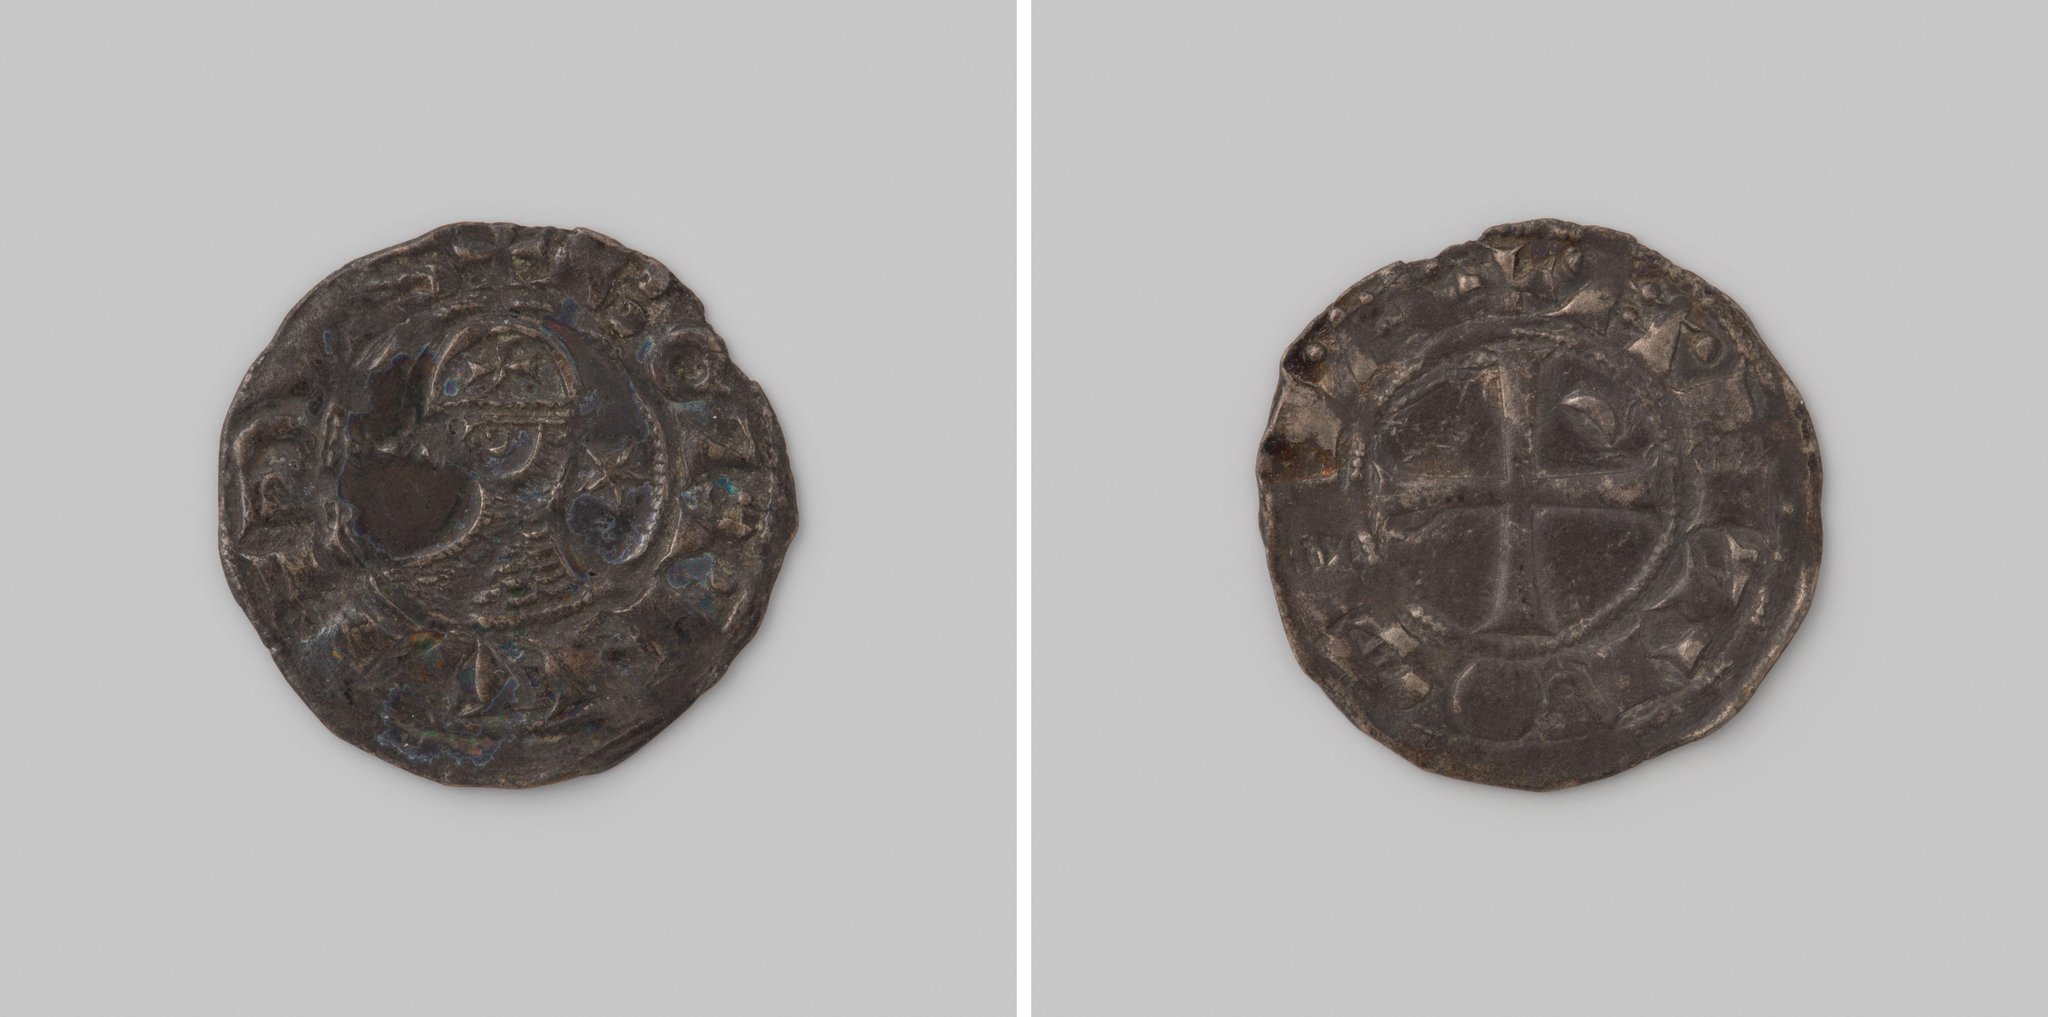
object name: coin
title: Vorstendom Antiochië, Bohemomd II,1201-1232, penning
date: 1201-1232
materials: silver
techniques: striking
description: Zilveren munt. Voorzijde: borstbeeld van de vorst met op zijn hoofd helm, waarop kruis. Rechts van hem ster. Keerzijde: kort gevoet kruis met in de eerste hoek een halve maan.